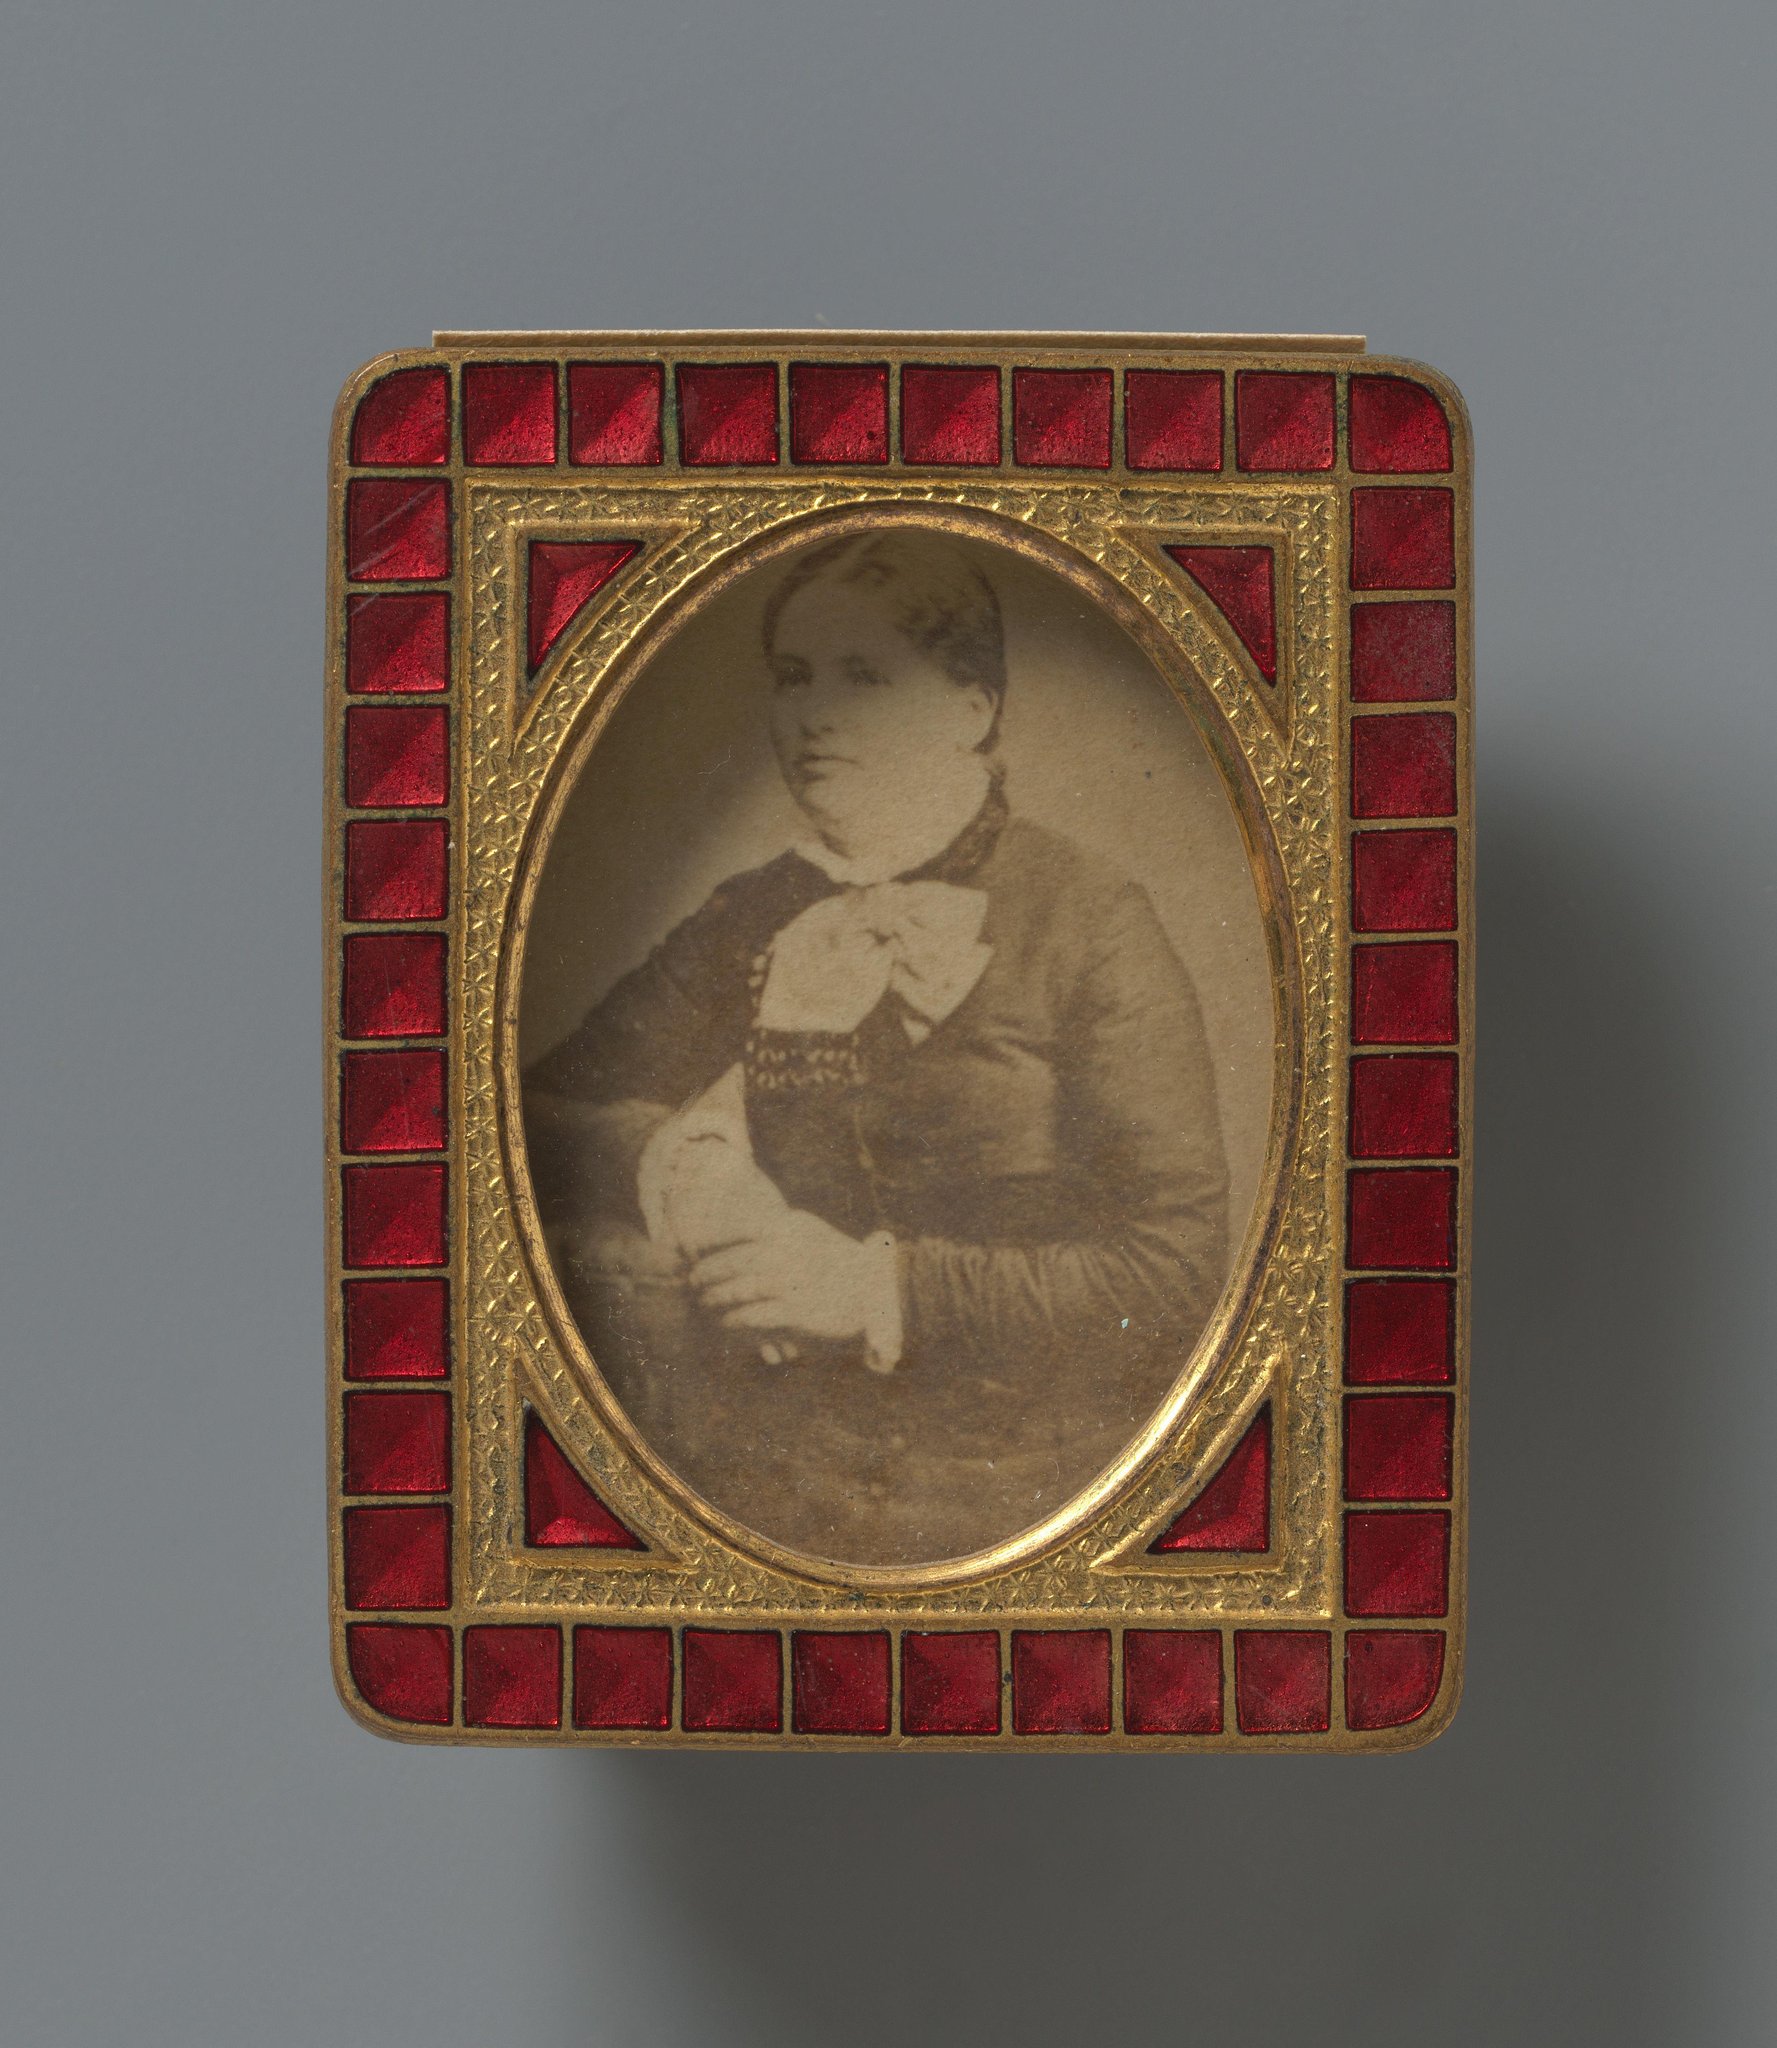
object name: photograph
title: Portret van een onbekende vrouw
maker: Anonymous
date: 1880-1910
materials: glass, metal, paper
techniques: albumen print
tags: anonymous historical person portrayed - bb - woman